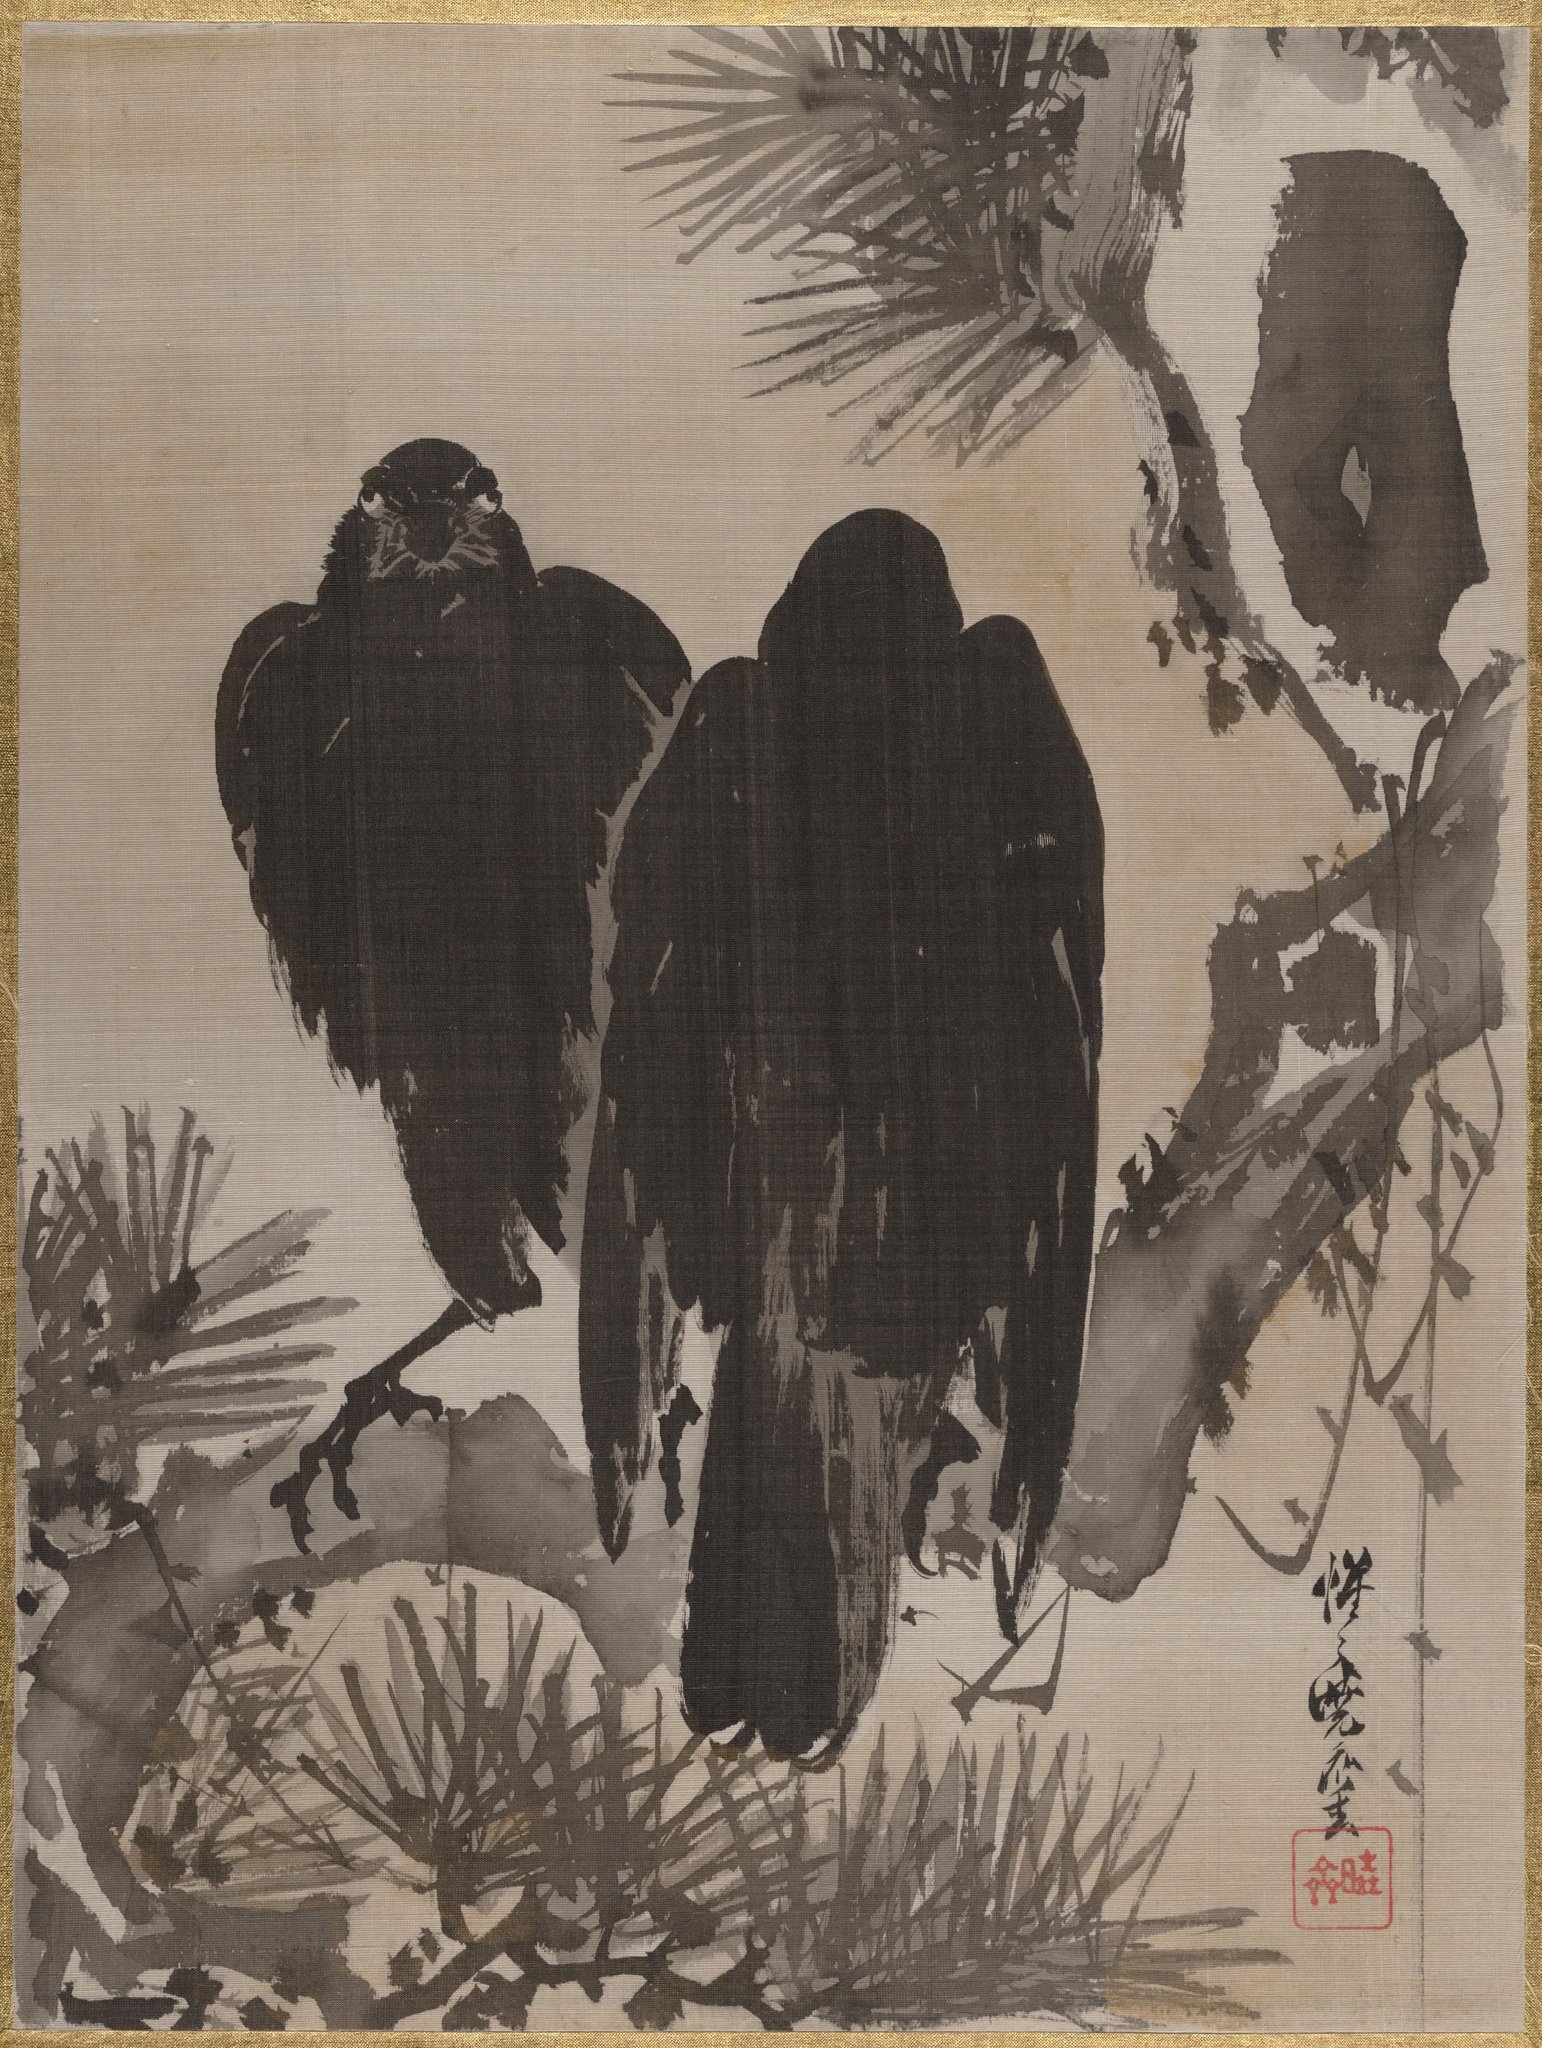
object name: album leaf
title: Two Crows on a Pine Branch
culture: japanese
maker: kawanabe kyōsai 河鍋暁斎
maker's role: artist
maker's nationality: japanese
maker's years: 1831-1889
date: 1887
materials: ink, silk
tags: birds